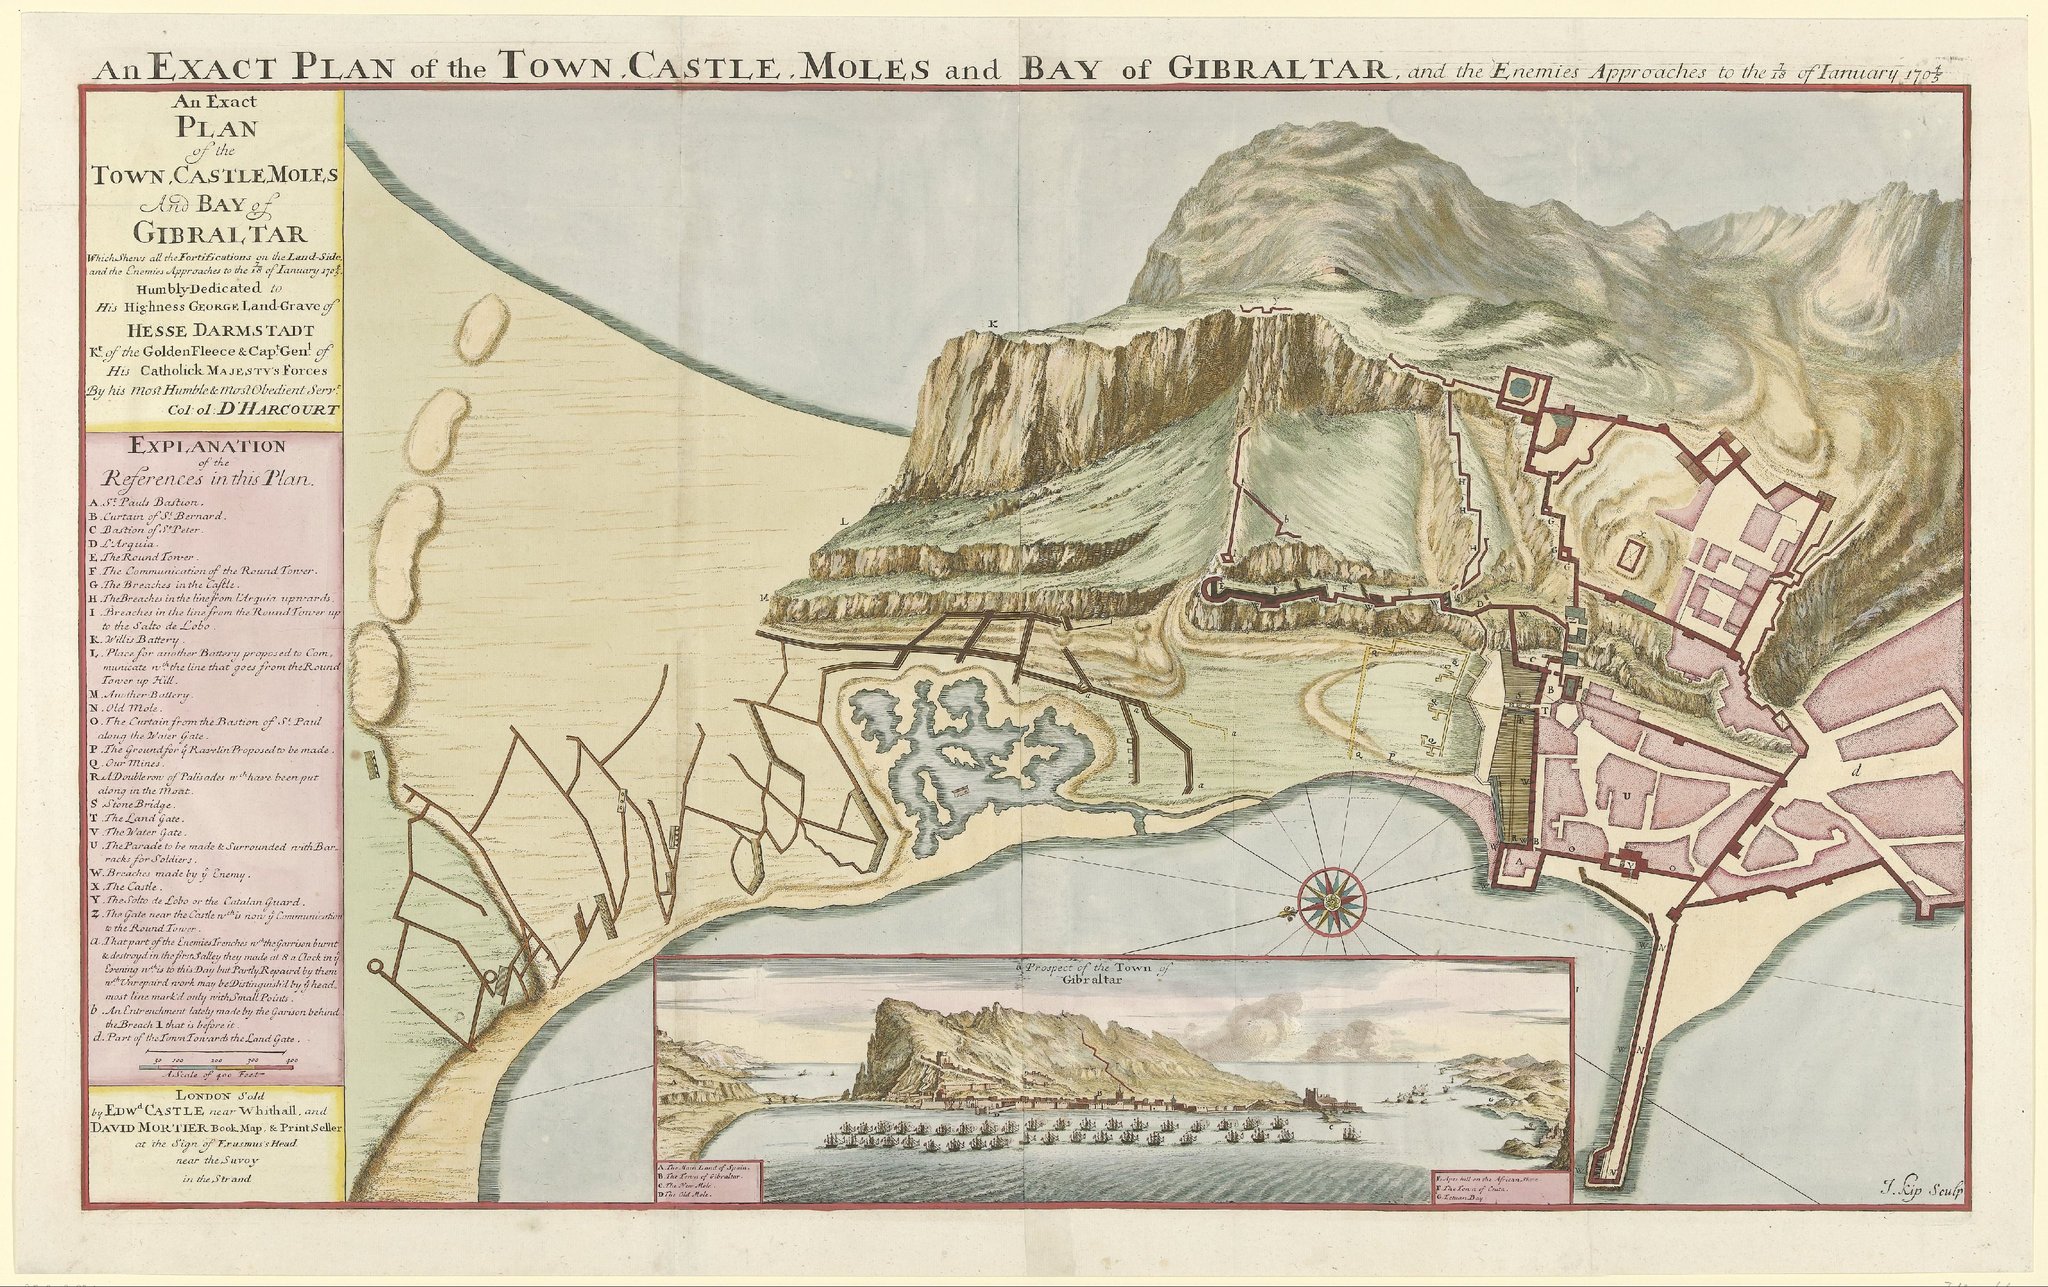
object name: print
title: An Exact Plan of the Town, Castle, Moles and Bay of Gibraltar, and the Eenemies Approaches to the 7/18 of January 1704/5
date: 1705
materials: paper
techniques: etching, hand coloring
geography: london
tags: siege, position war, maps of cities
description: Kaart van Gibraltar, belegerd door de Fransen en Spanjaarden in januari 1705. Onderaan een inzet met een gezicht op Gibraltar. Links de legenda A-Z en a-d in het Engels.